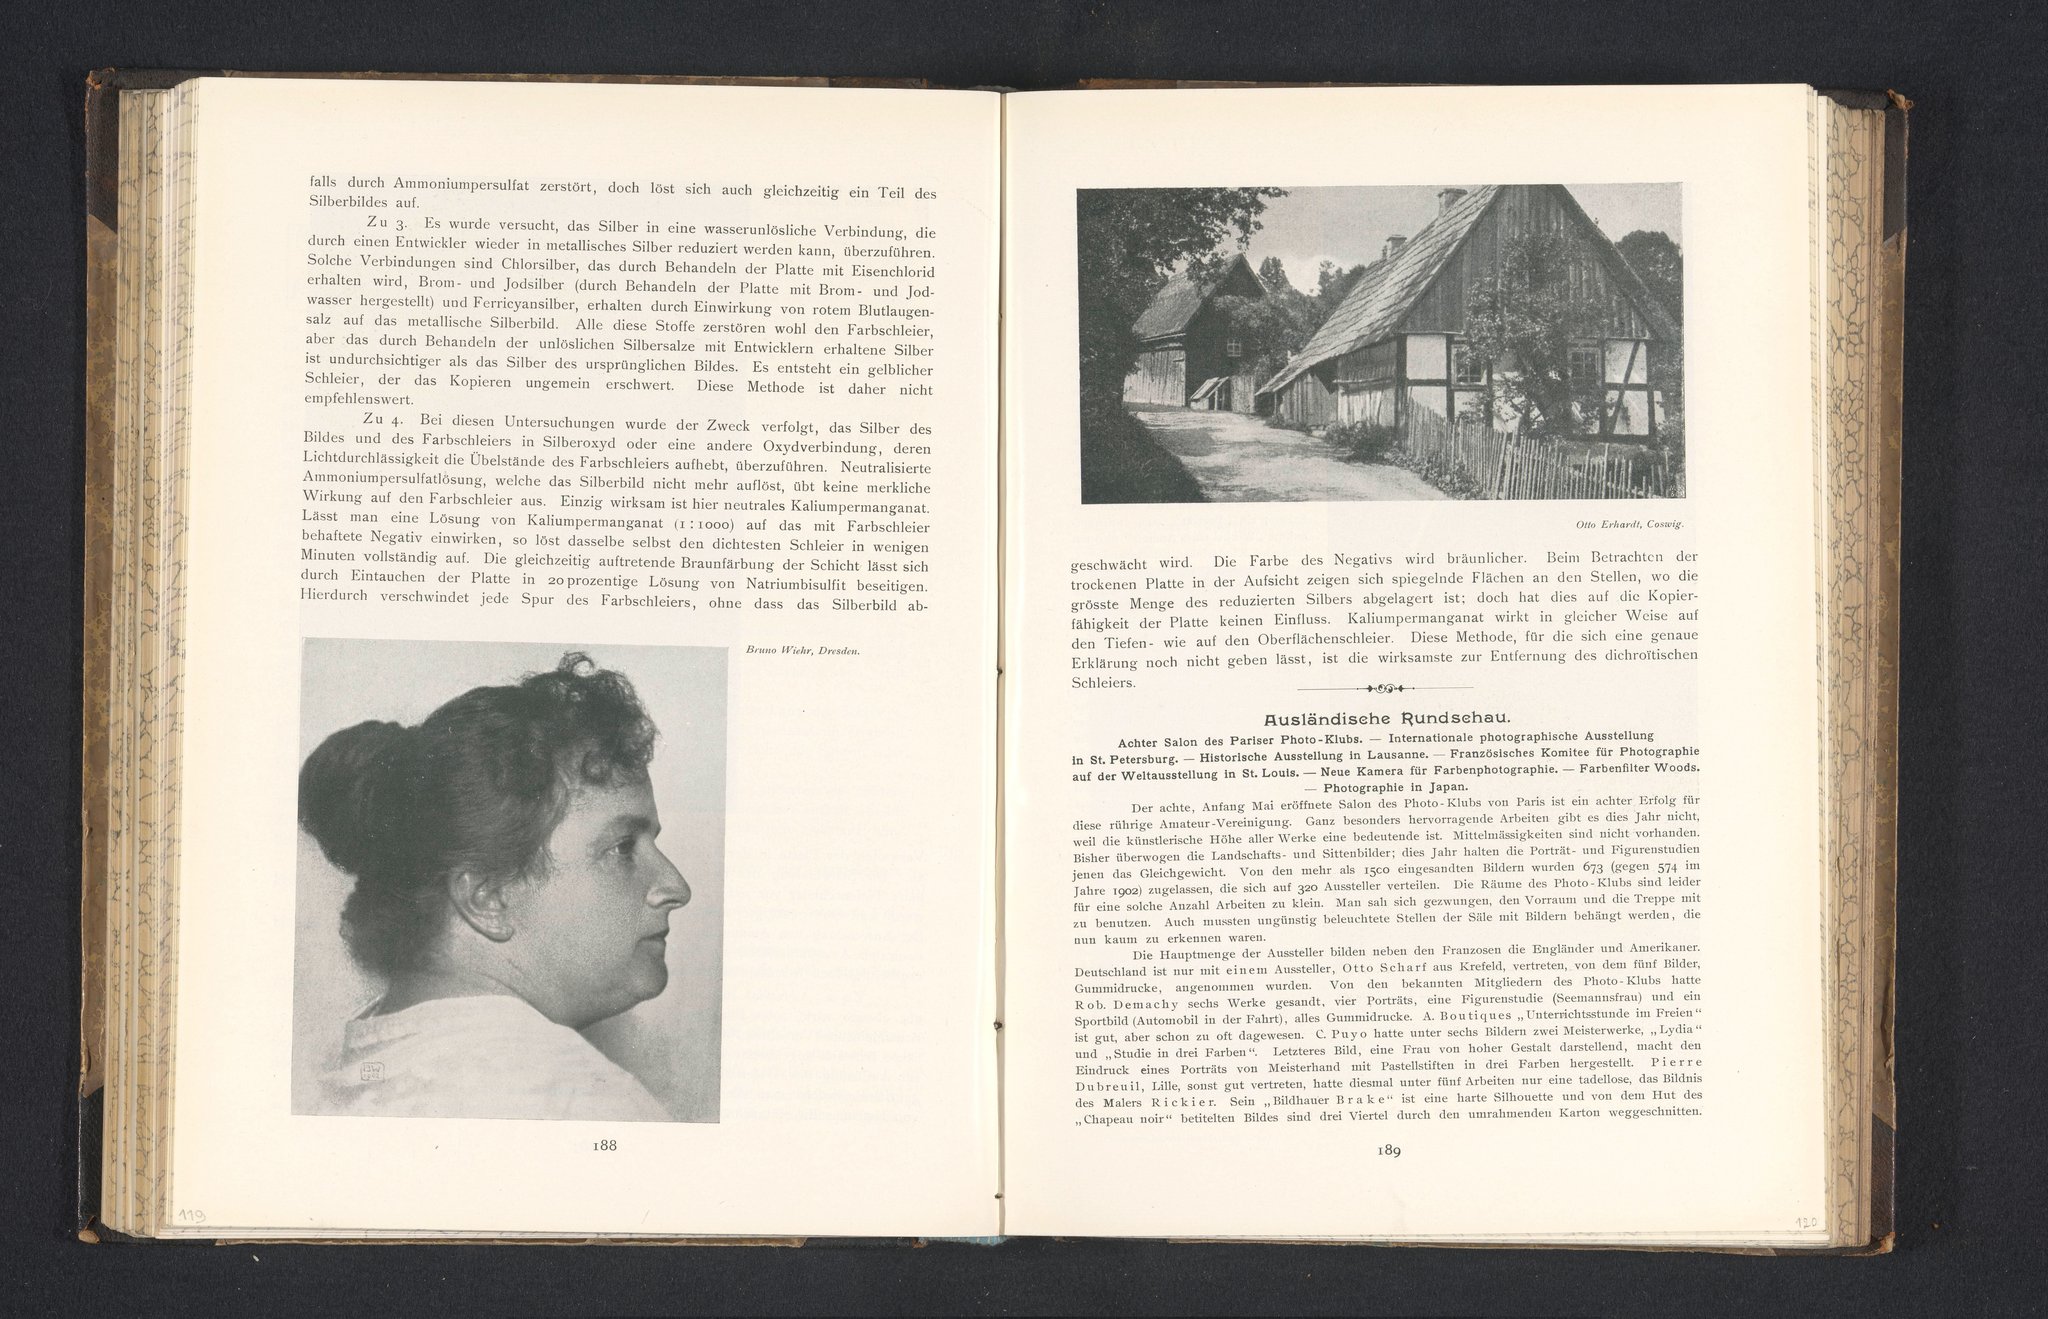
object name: page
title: Portret van een onbekende vrouw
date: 1902-1903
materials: paper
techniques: autotype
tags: historical persons not known by name - bb - woman